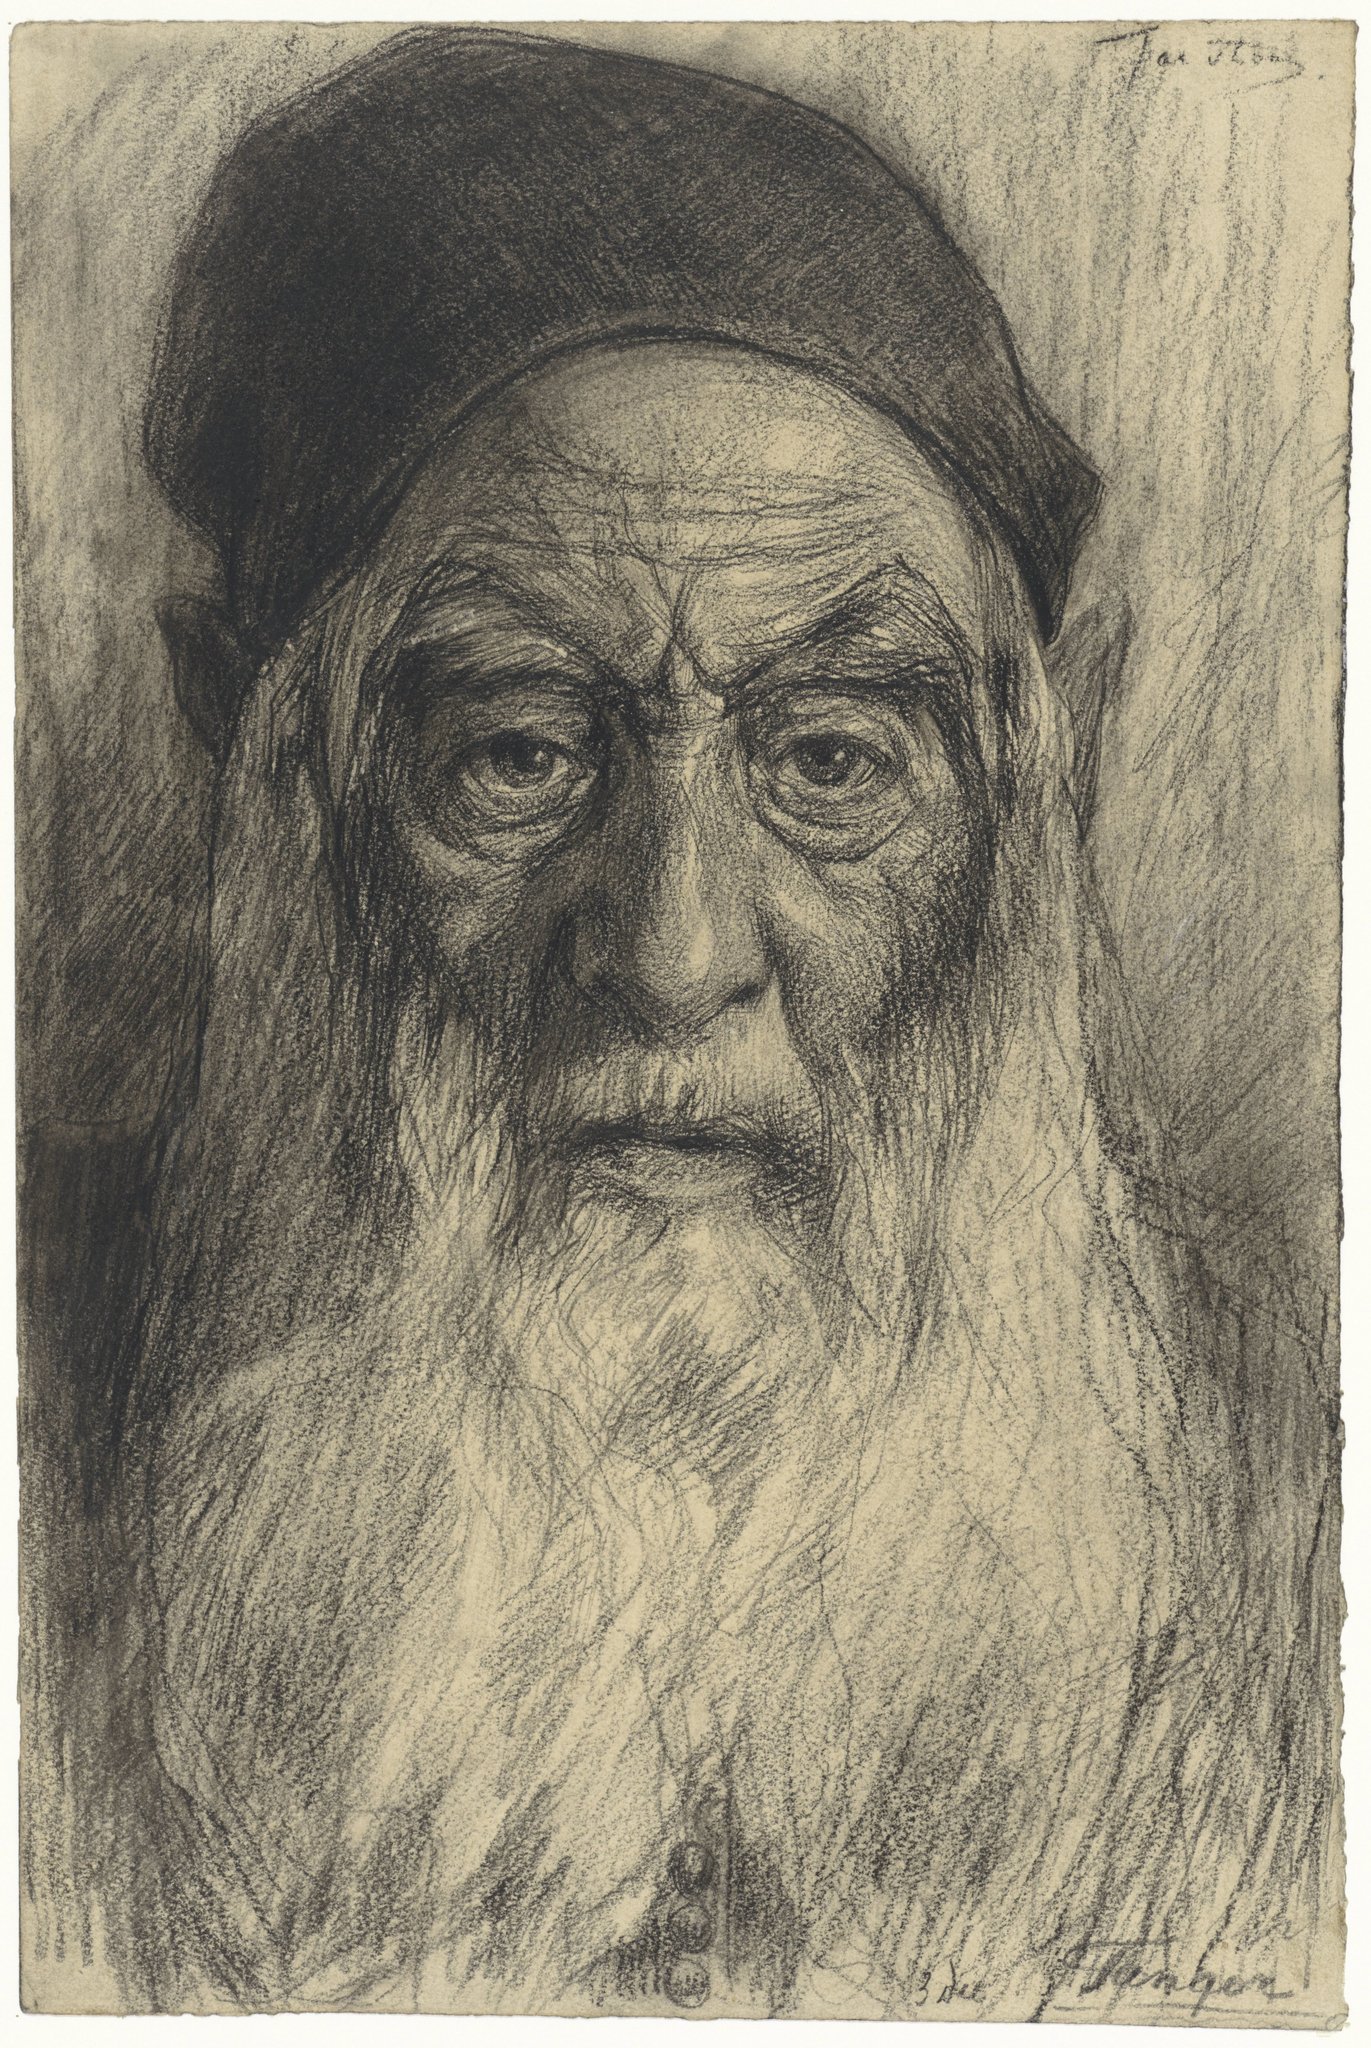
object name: drawing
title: Kop van een oude man met baard, te Tanger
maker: jac van looij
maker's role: draughtsman, painter, print maker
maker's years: 1855-1930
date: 1865-1922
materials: chalk, paper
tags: africans (maroccans)